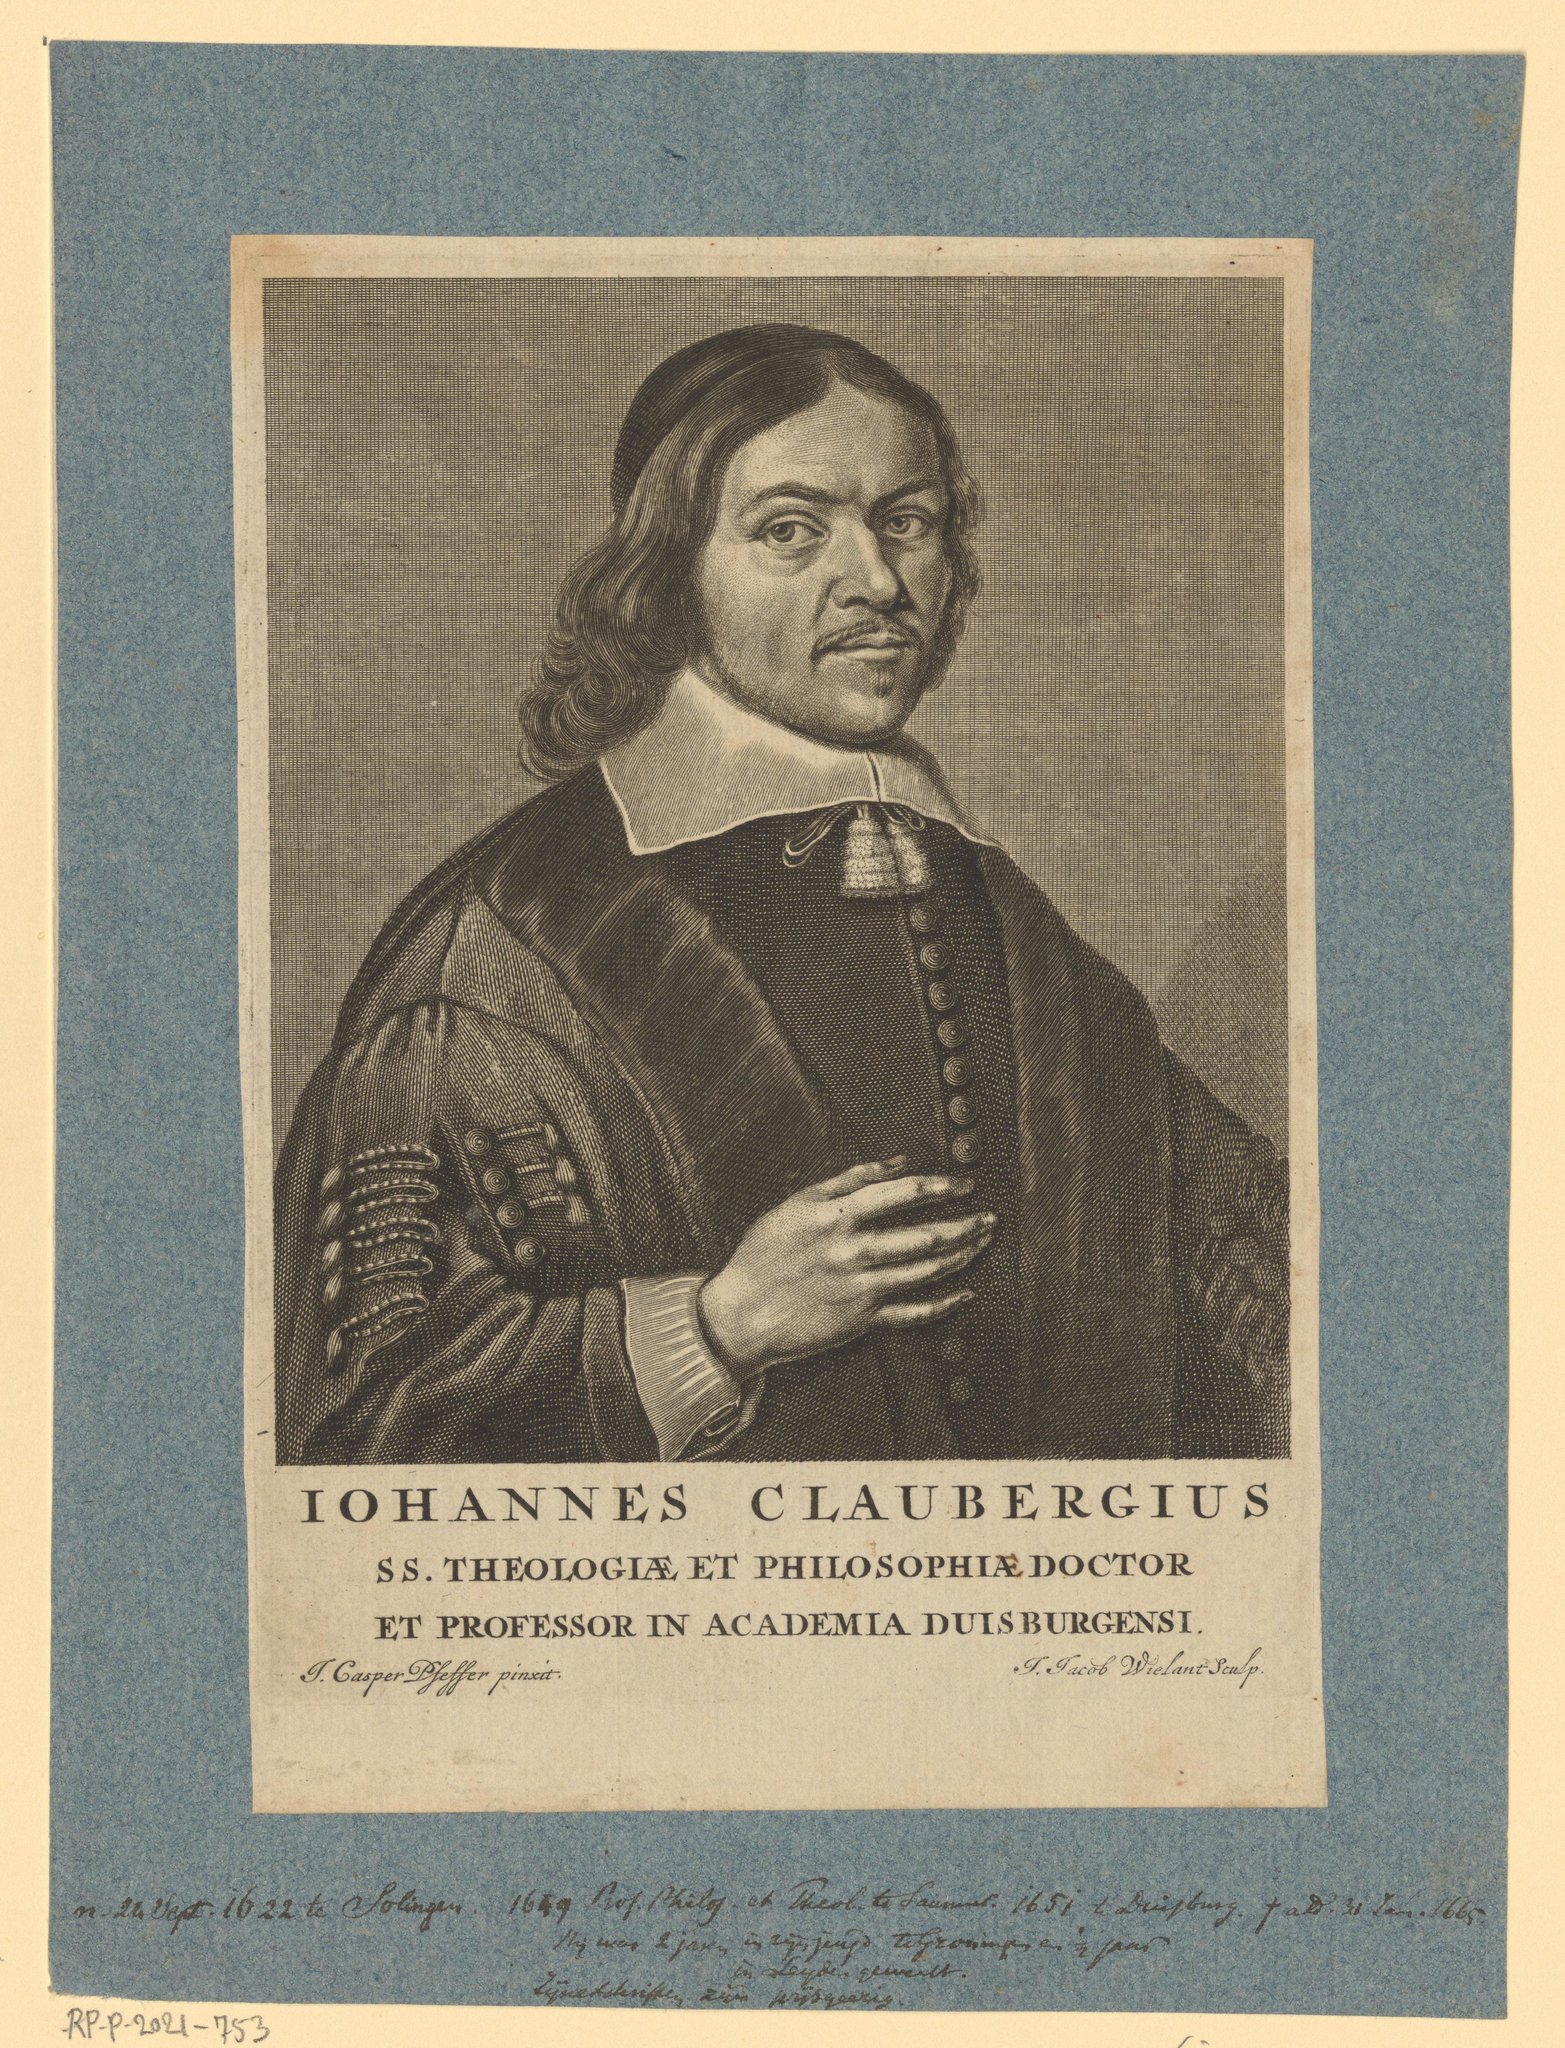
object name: print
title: Portret van Johannes Clauberg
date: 1691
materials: paper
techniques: engraving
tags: solingen, historical persons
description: Prent mogelijk uit: Clauberg, Johannes. Opera omnia philosophica (...). Amsterdam: Officina Janssonius van Waesberge et al., 1691.